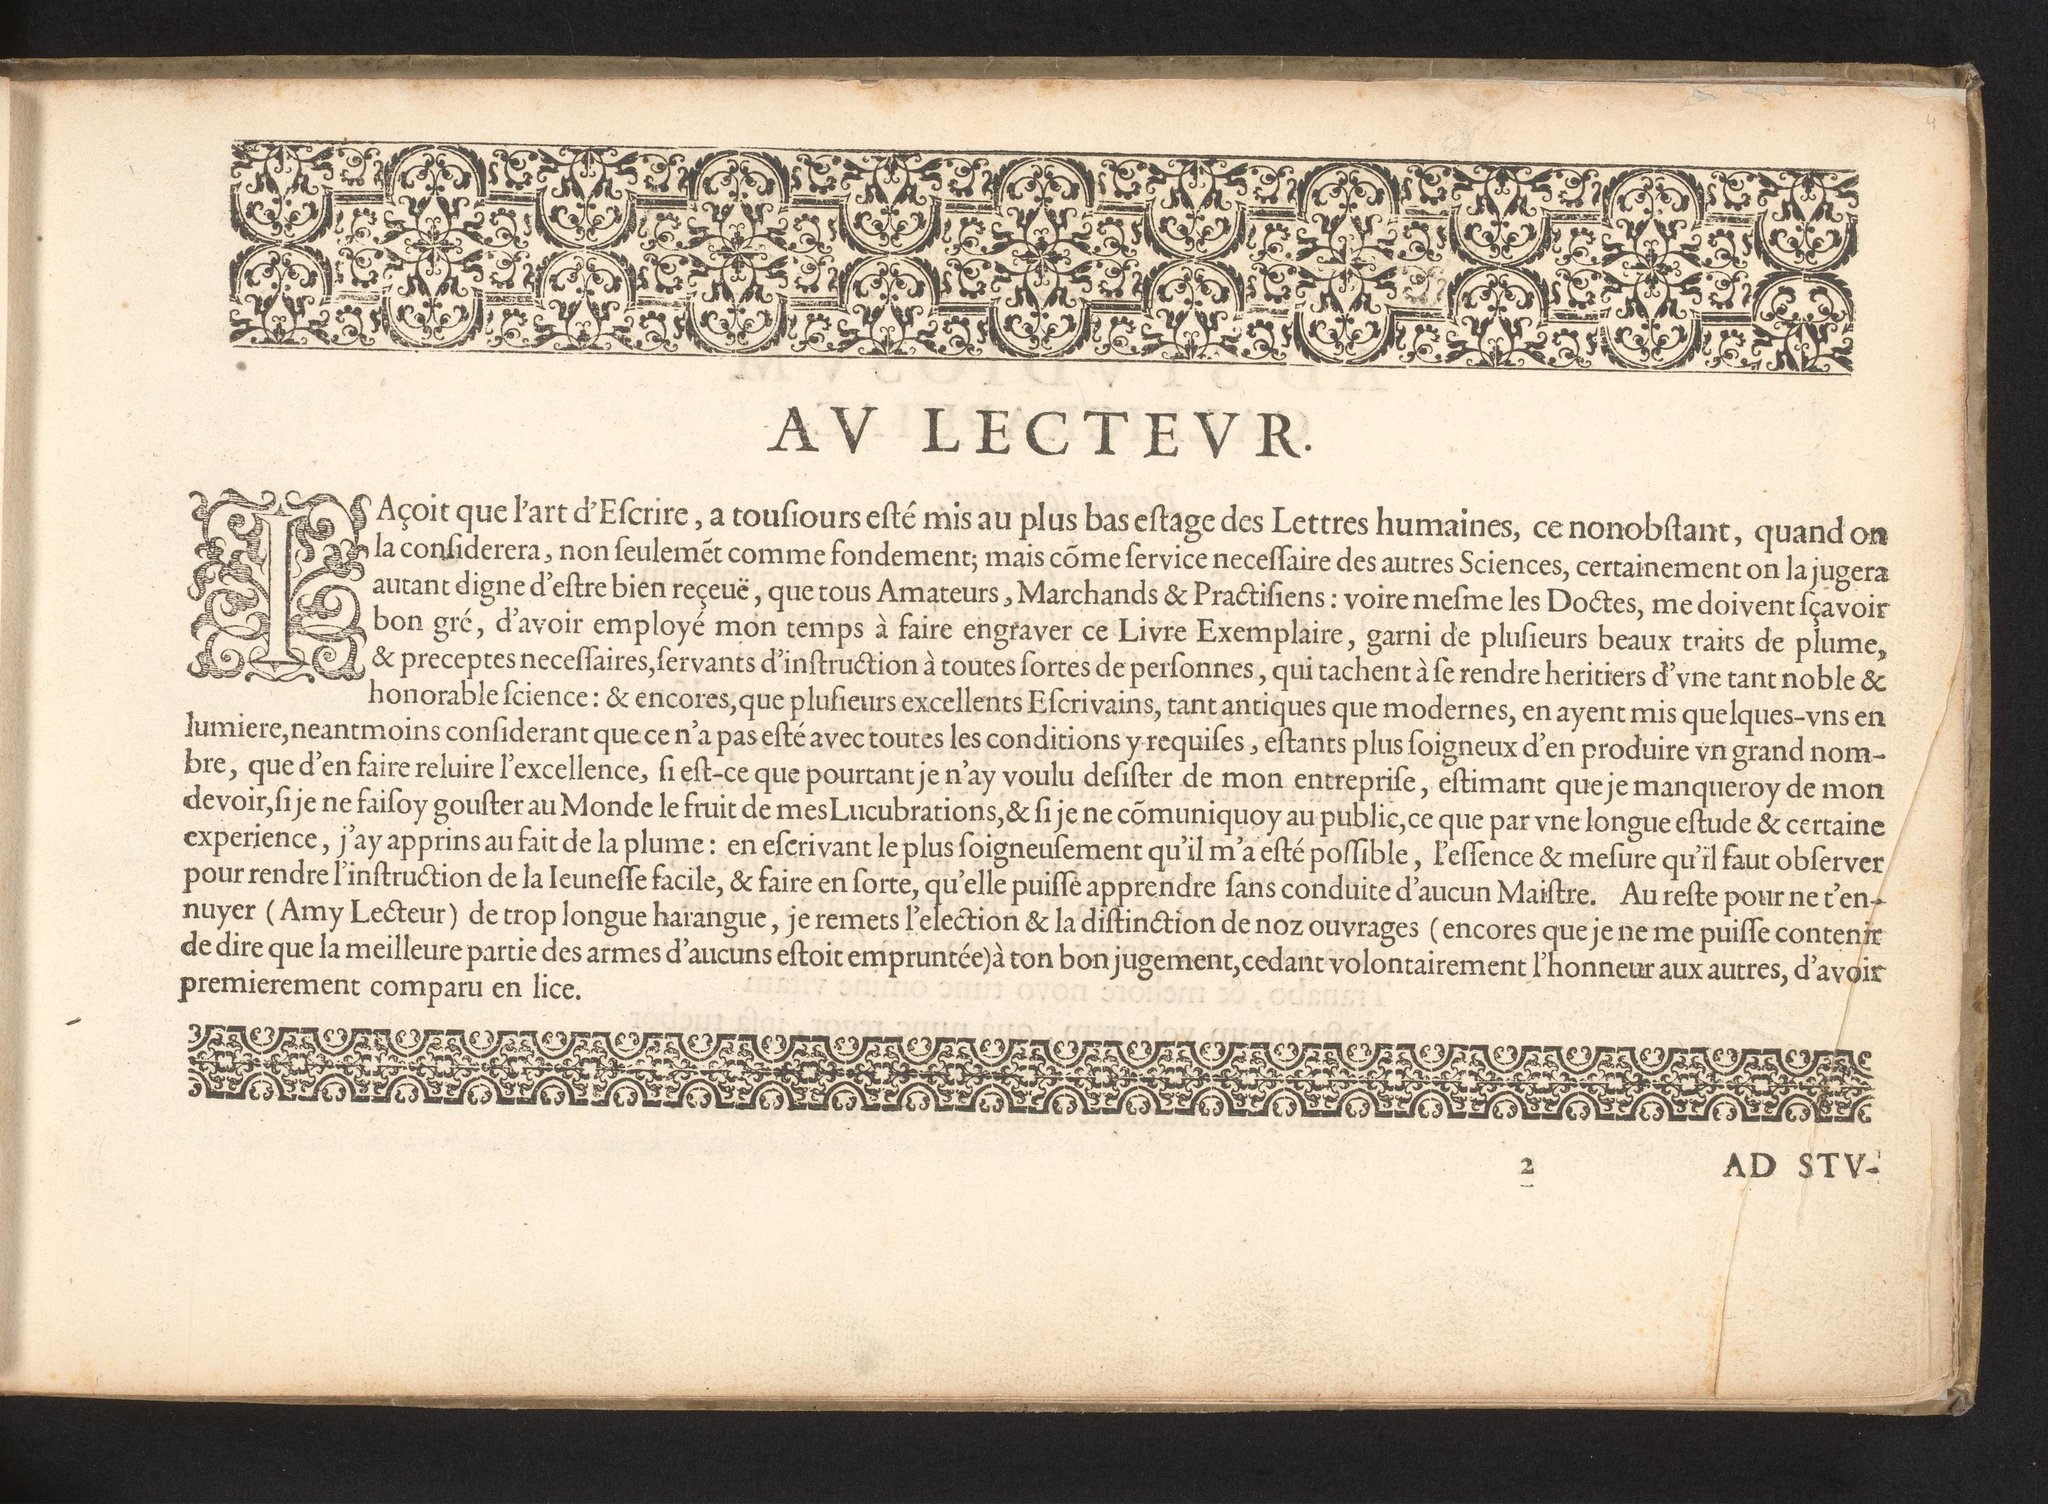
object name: album leaf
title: Spieghel der schrijfkonste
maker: jan van de velde (i)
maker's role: painter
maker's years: 1568-1623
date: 1605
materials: paper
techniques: letterpress printing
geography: rotterdam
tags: initial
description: Tekstblad getiteld: Au Lecteur. De tekst begint met een gedecoreerde initiaal I. Boven- en onderaan een ornamentrand van fleurons. Het tekstblad maakt deel uit van een album.